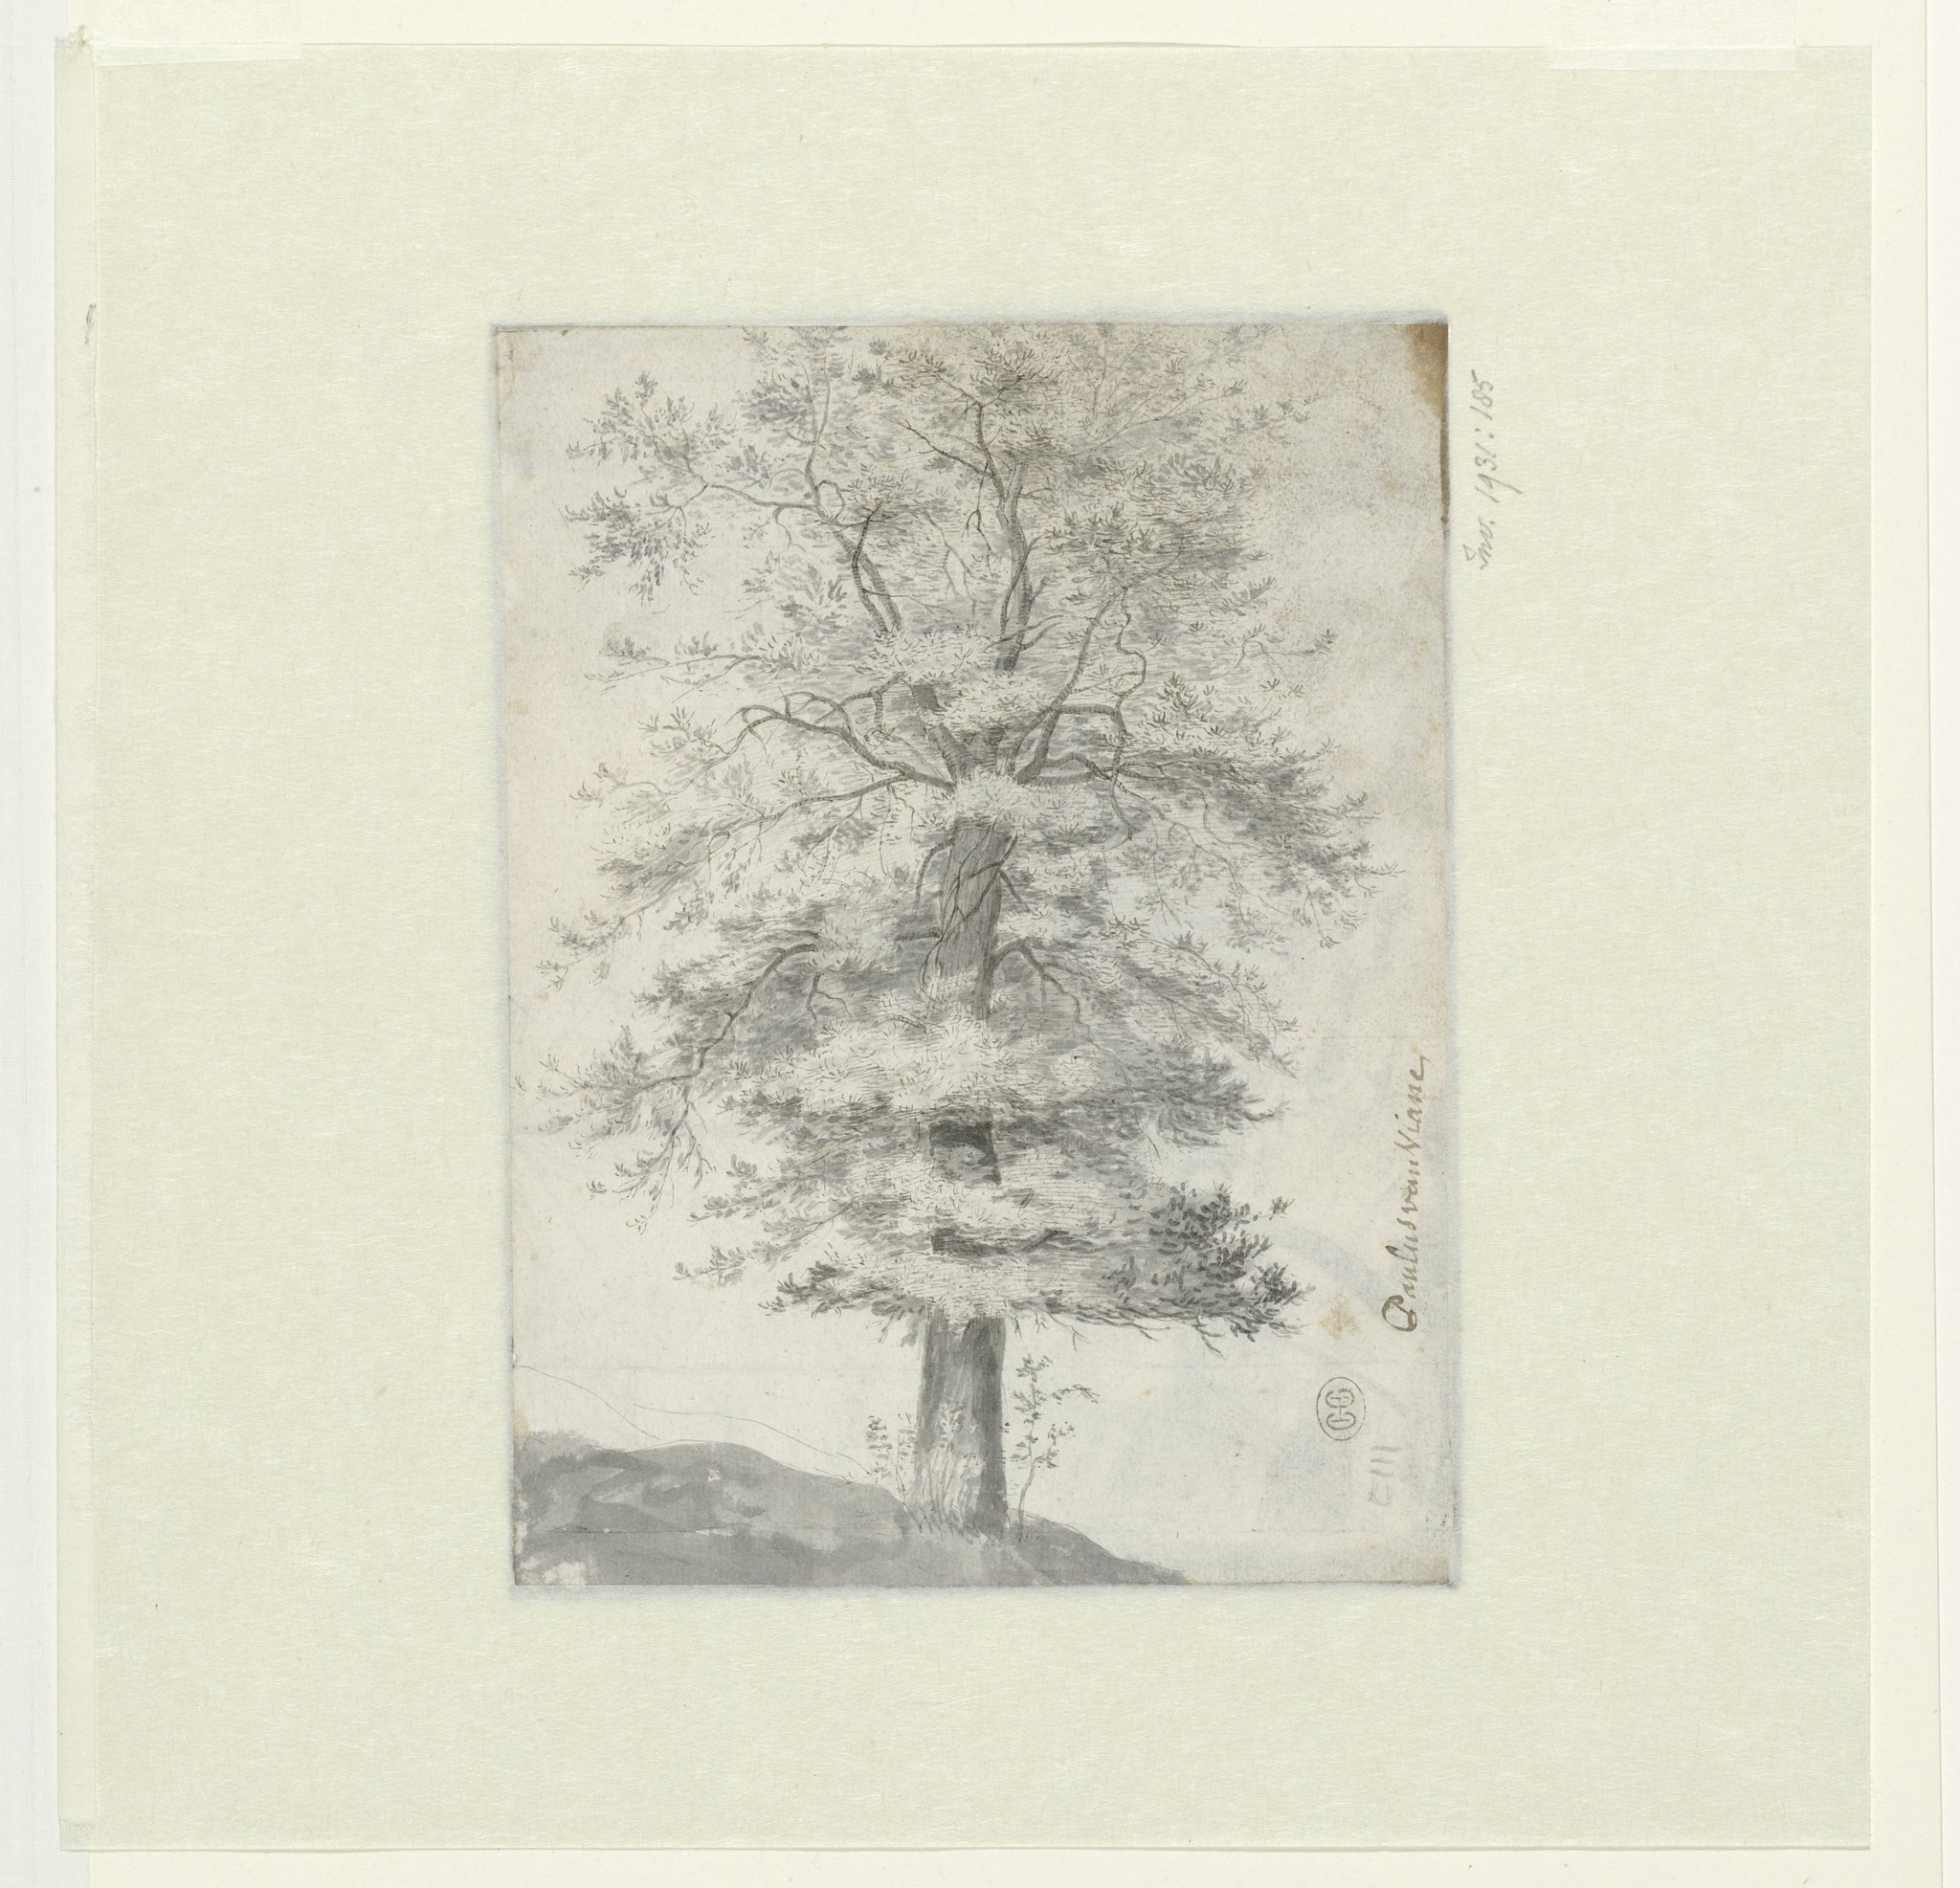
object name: drawing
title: Studie van een boom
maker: paulus willemsz. van vianen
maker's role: draughtsman, jeweler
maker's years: 1570-1614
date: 1603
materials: ink, paper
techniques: brush, pen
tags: trees